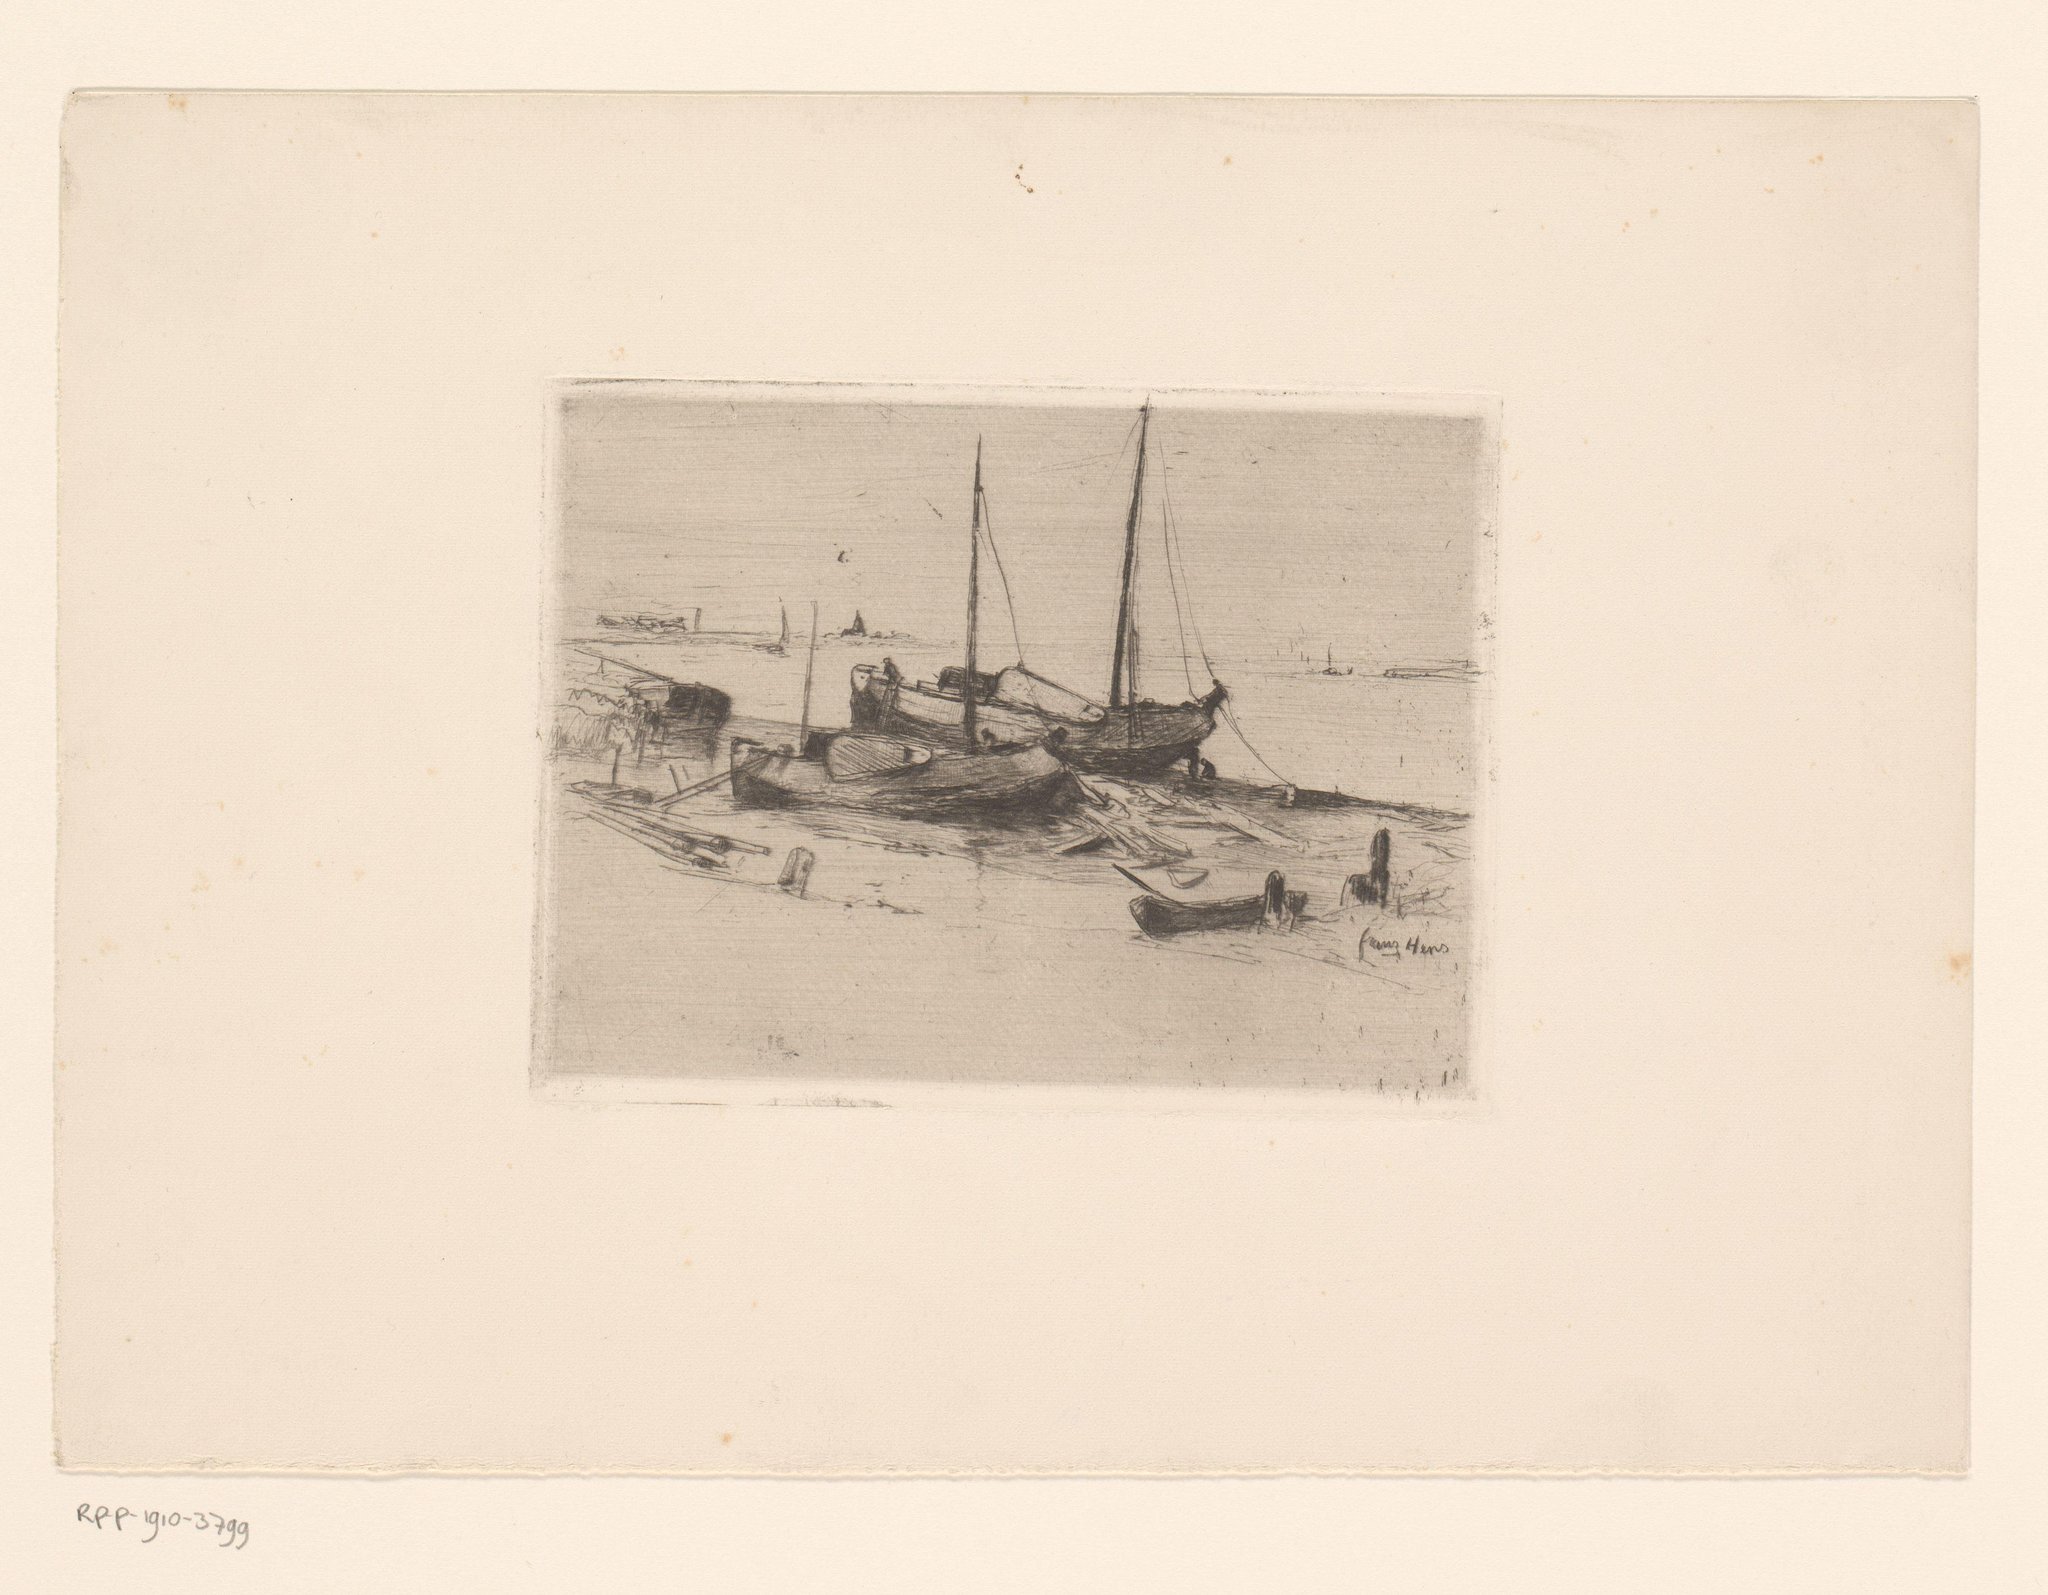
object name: print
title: Twee schepen met zwaarden op het strand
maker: frans hens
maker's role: print maker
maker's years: 1856-1928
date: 1866-1910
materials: paper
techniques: etching, intaglio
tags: ships, boats on land, beached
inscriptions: collector's mark: Lugt 2228